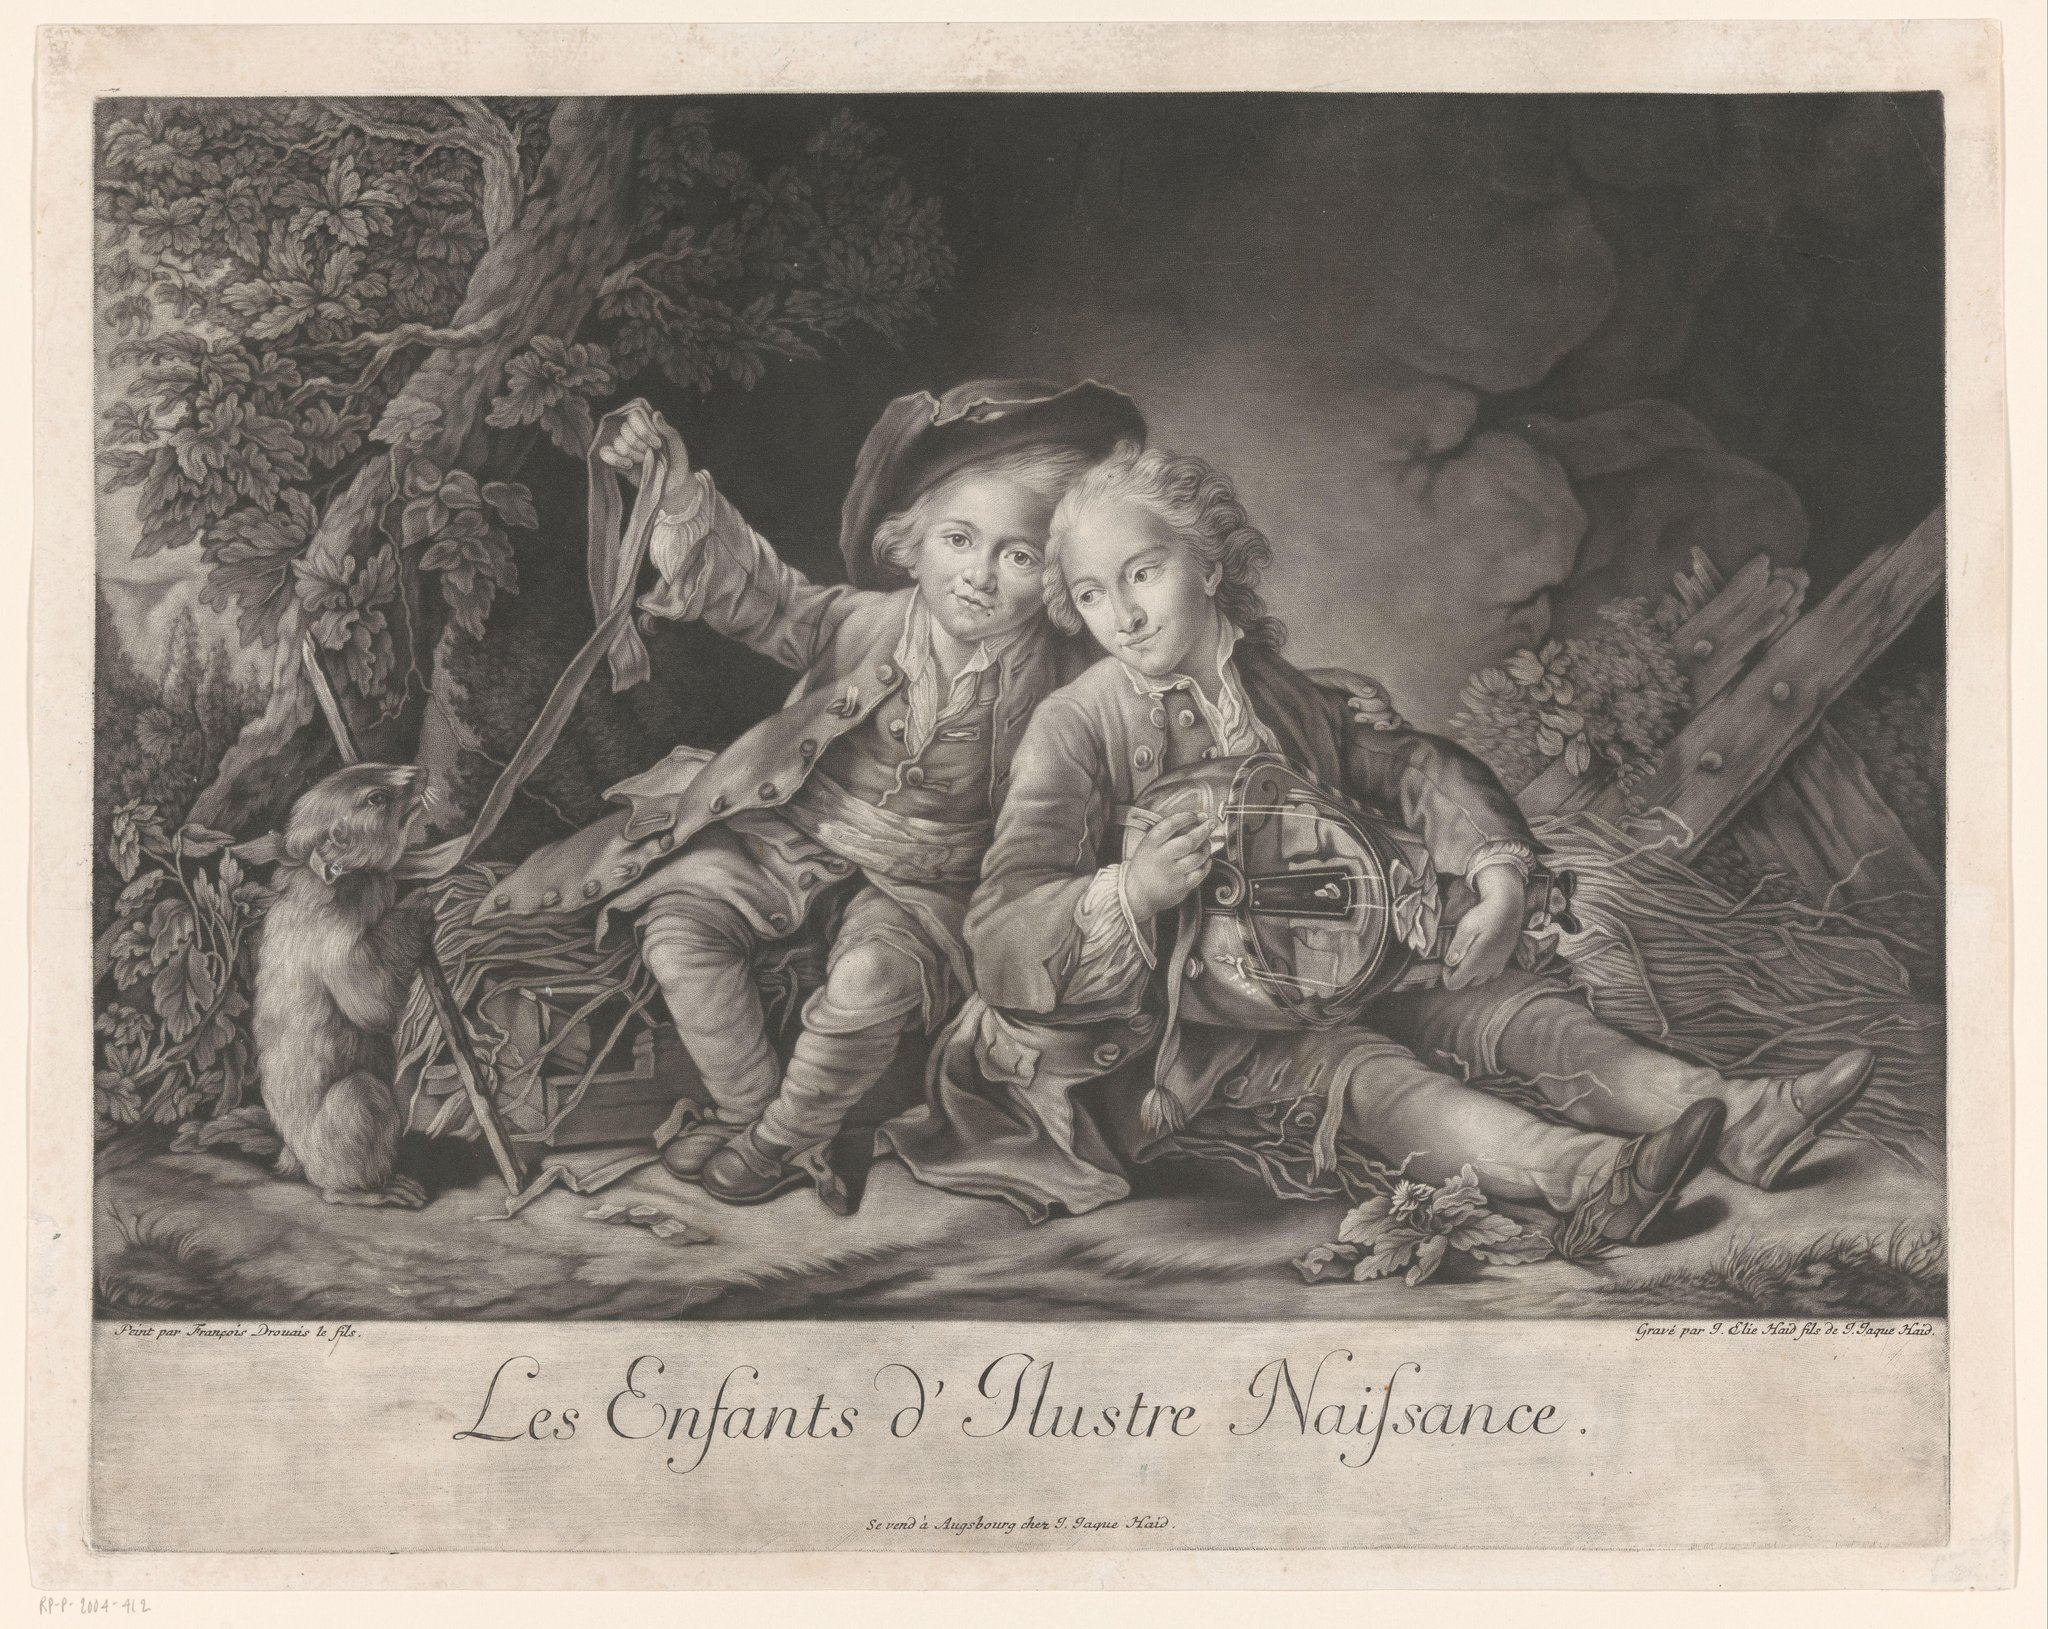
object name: print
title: Les Enfants d' Ilustre Naissance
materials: paper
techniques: mezzotint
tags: boy (child between toddler and youth), earning money with guinea-pig, hurdy-gurdy player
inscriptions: collector's mark: Lugt 2228, collector's mark: Lugt 2760